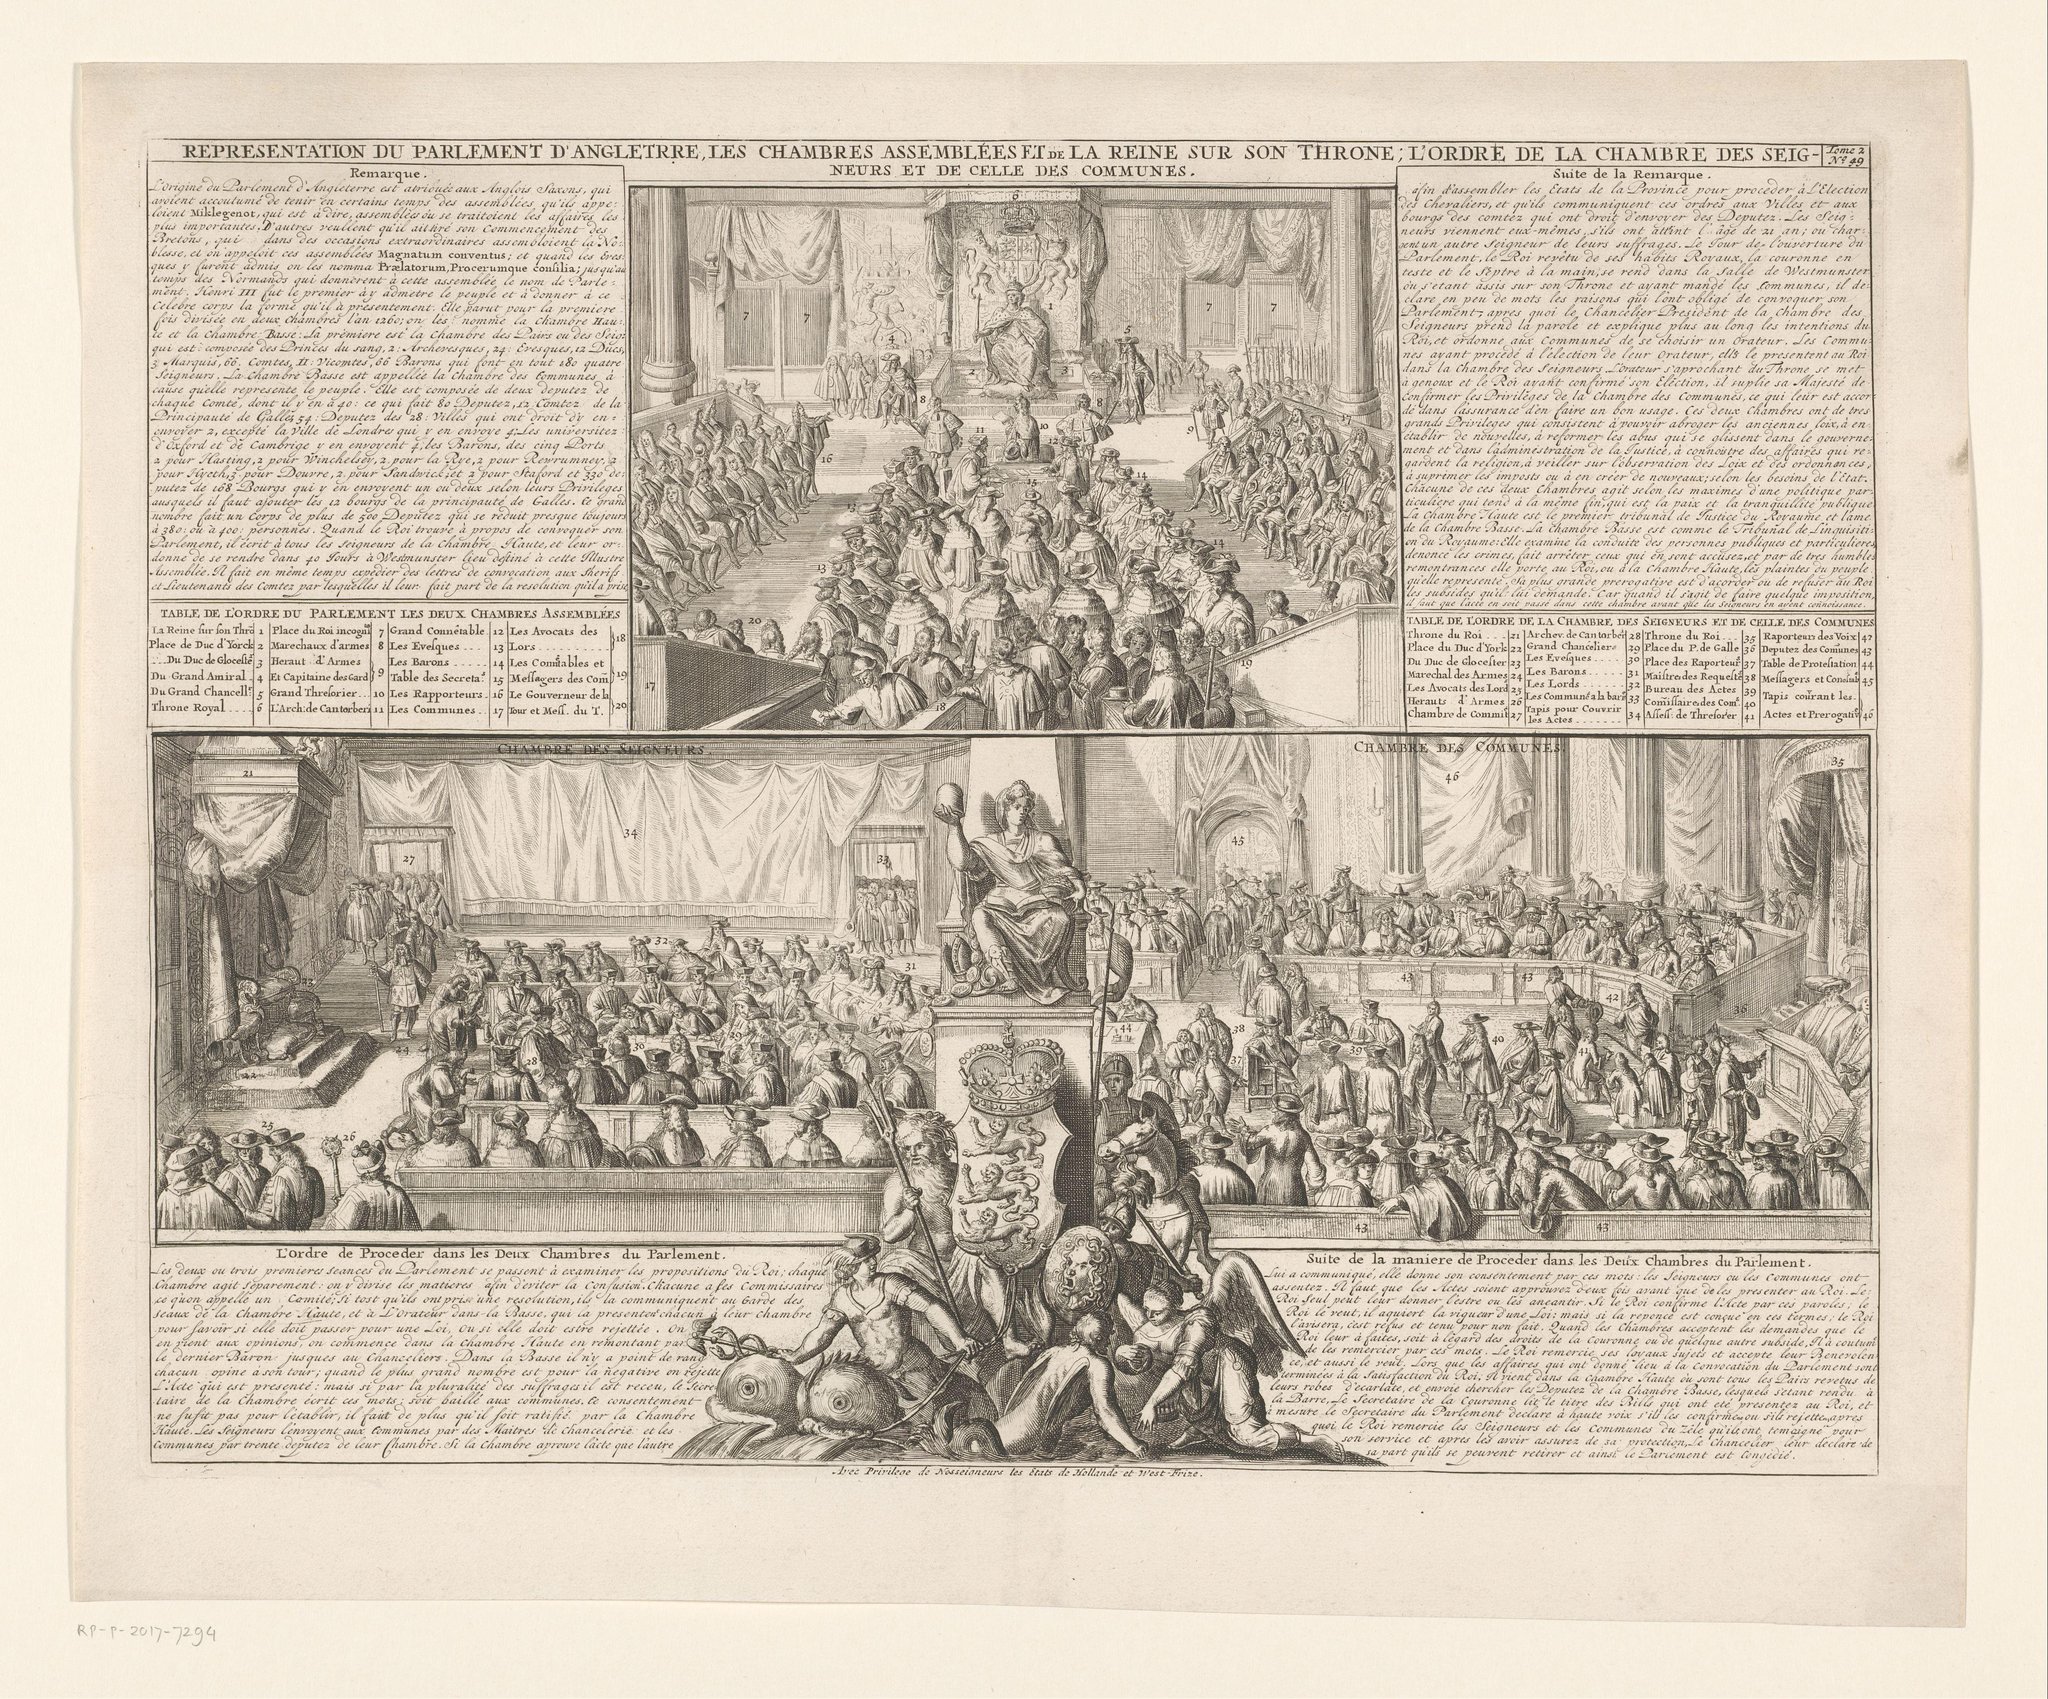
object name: print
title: Zitting van het Engelse parlement, 1708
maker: Anonymous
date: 1706-1708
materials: paper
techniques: engraving, etching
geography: low countries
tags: london, anna stuart (koningin van engeland en schotland), upper house, senate, lower house, parliament, chamber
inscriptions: collector's mark: Lugt 2228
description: Blad over de gebruiken van het Engelse parlement,1708. Boven een voorstelling van een gezamenlijke zitting van het Hoger- en het Lagerhuis, voorgezeten door de koningin. Onderaan links een zitting van het Hogerhuis, rechts het Lagerhuis. Met legenda's en uitleg in het Frans. Rechtsbovenaan gemerkt: Tome 2 No. 49. Uit Chatelains Atlas Historique.